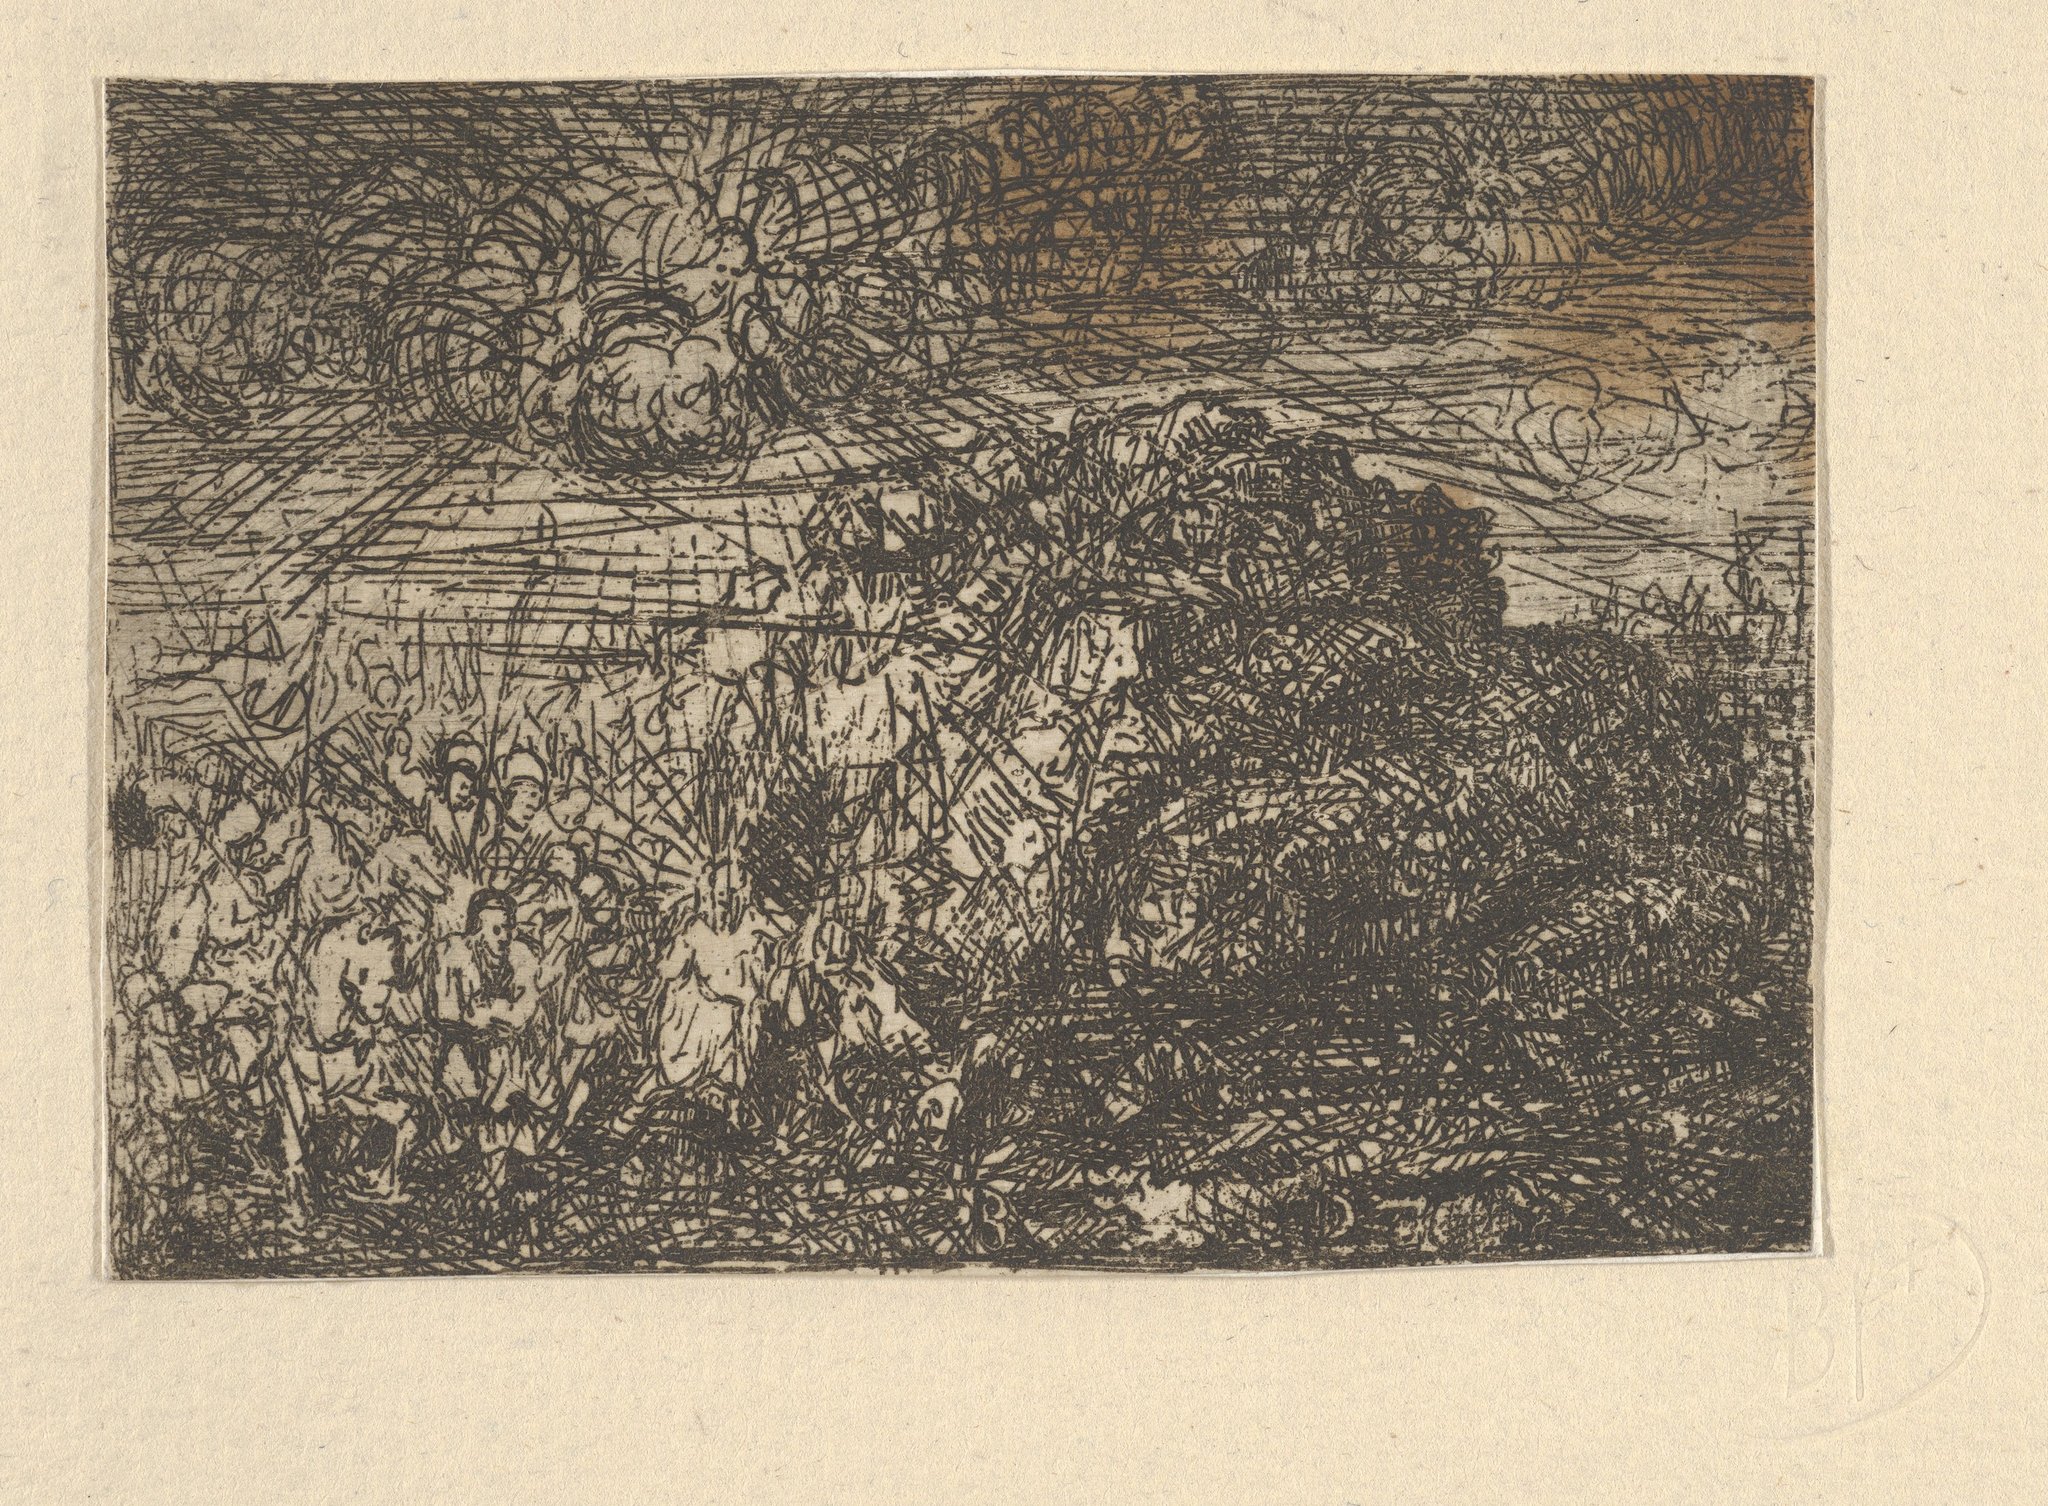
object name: print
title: L'Arrestation du Christ (The Arrest of Christ)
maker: rodolphe bresdin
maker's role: artist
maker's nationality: french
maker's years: 1822-1885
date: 1801-1900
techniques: etching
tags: human figures